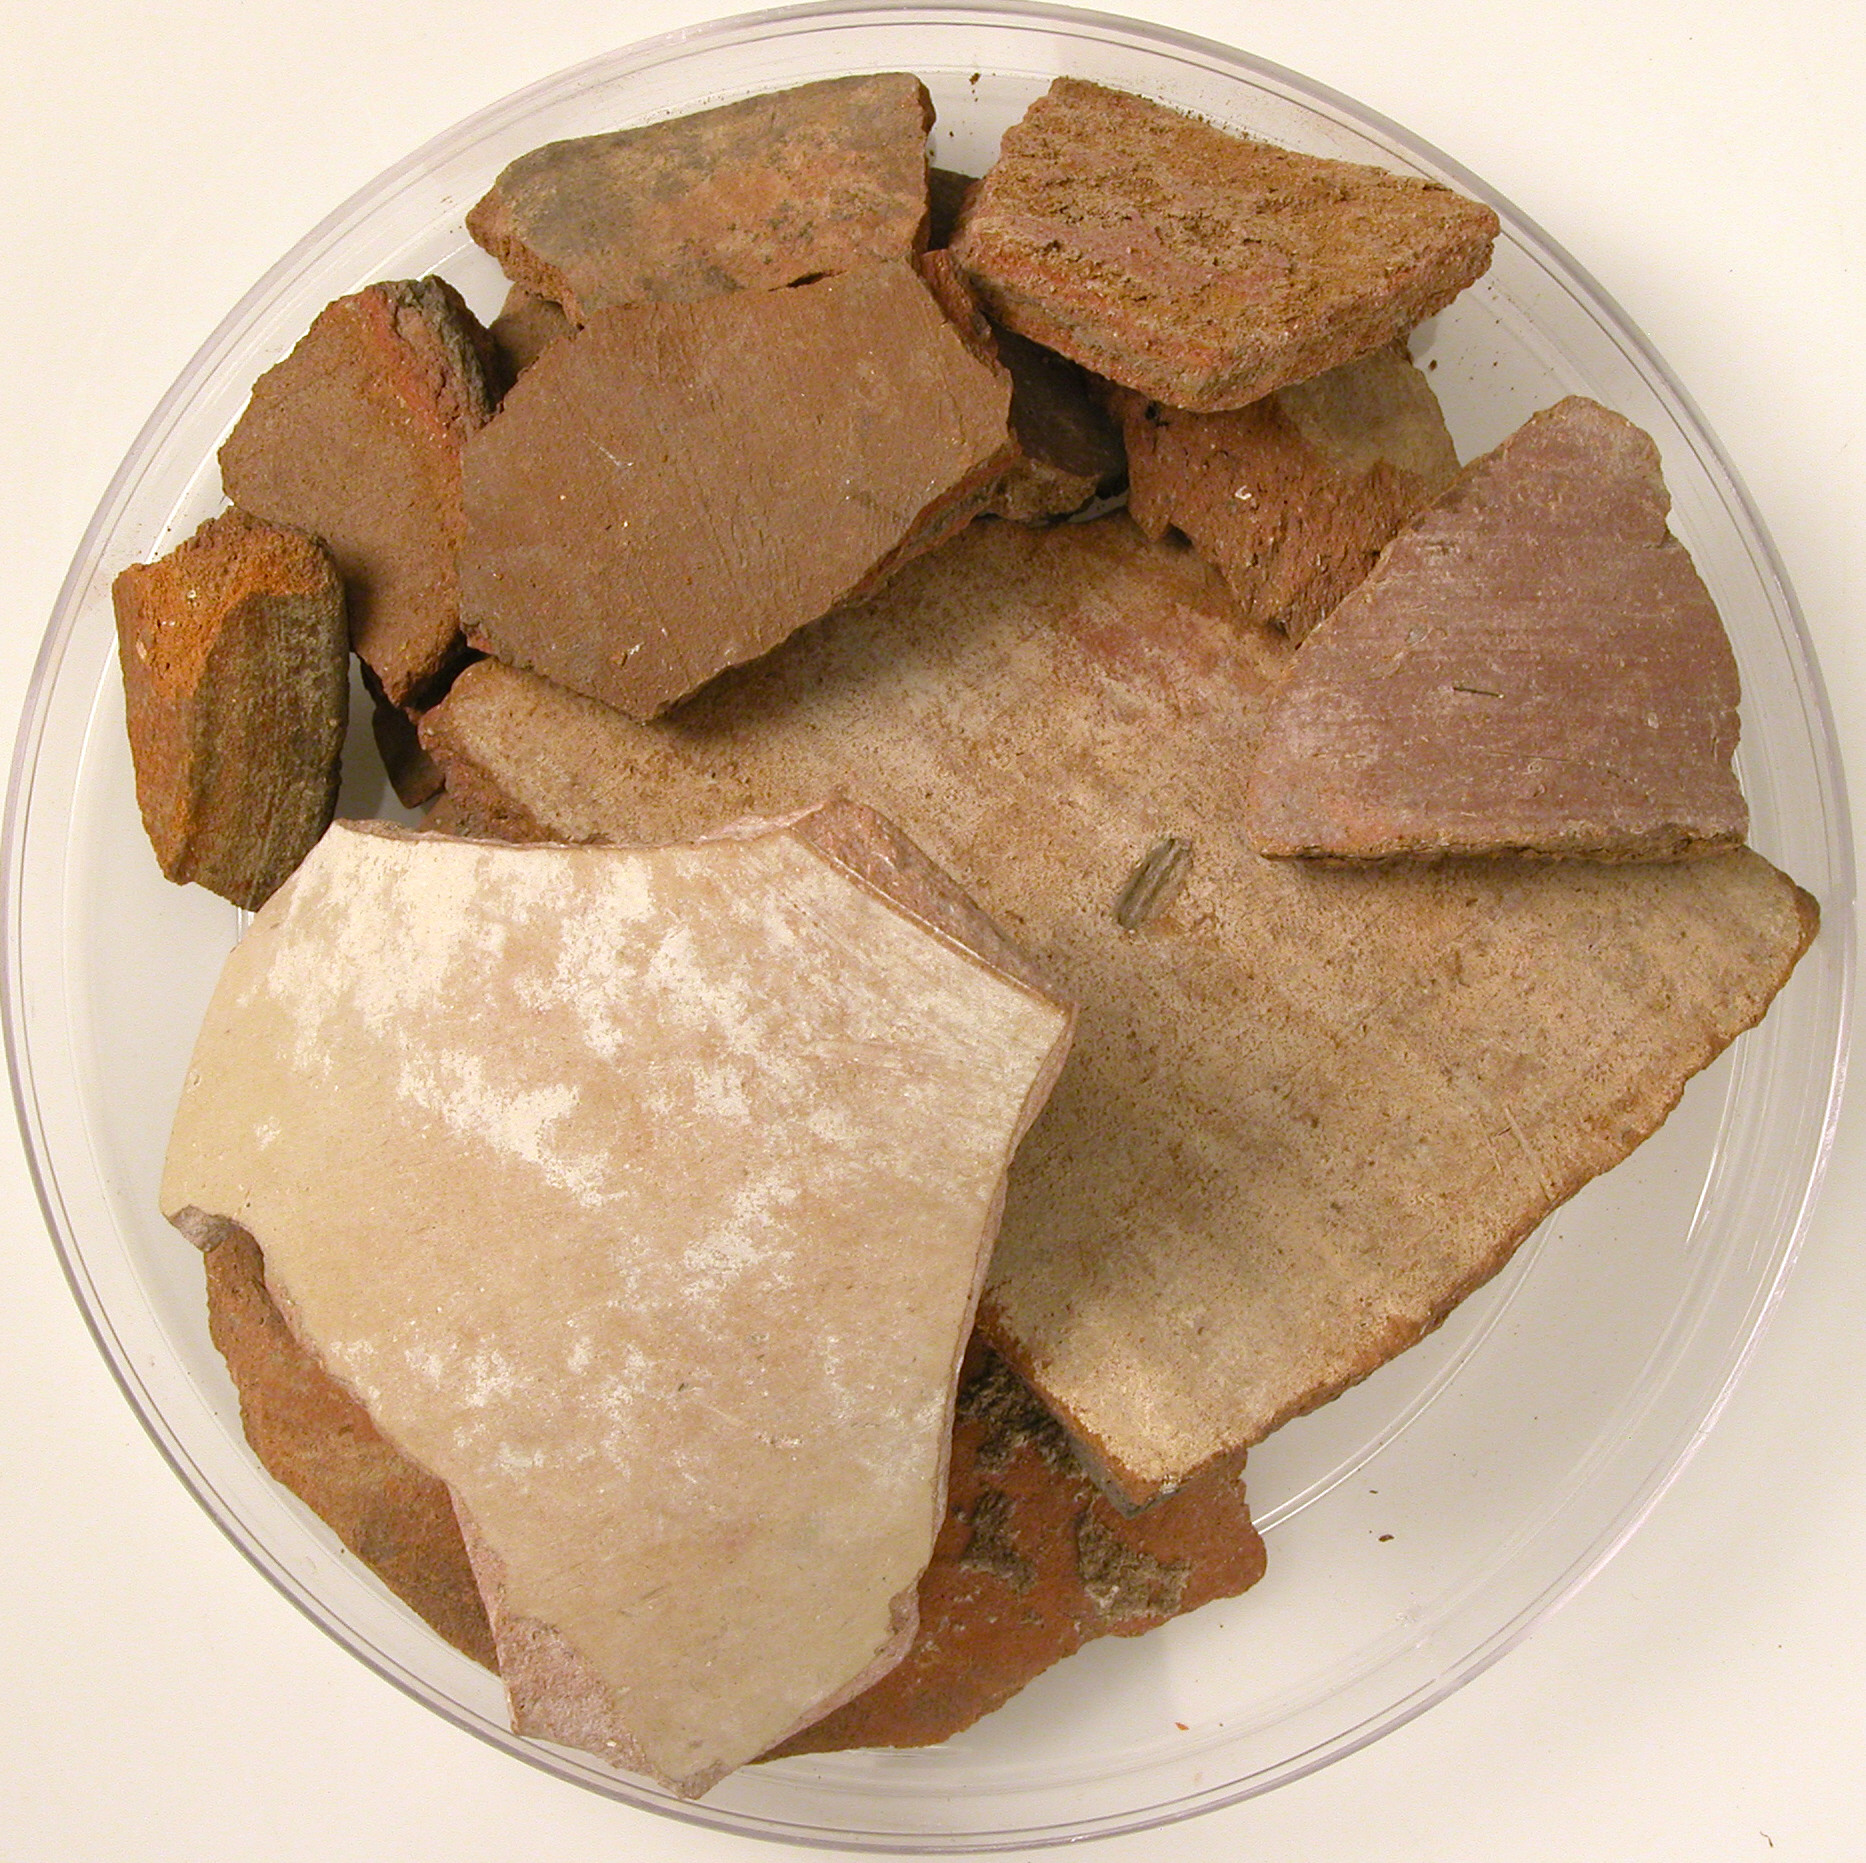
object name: fragment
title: Pottery Fragments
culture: coptic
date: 301-700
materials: earthenware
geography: egypt